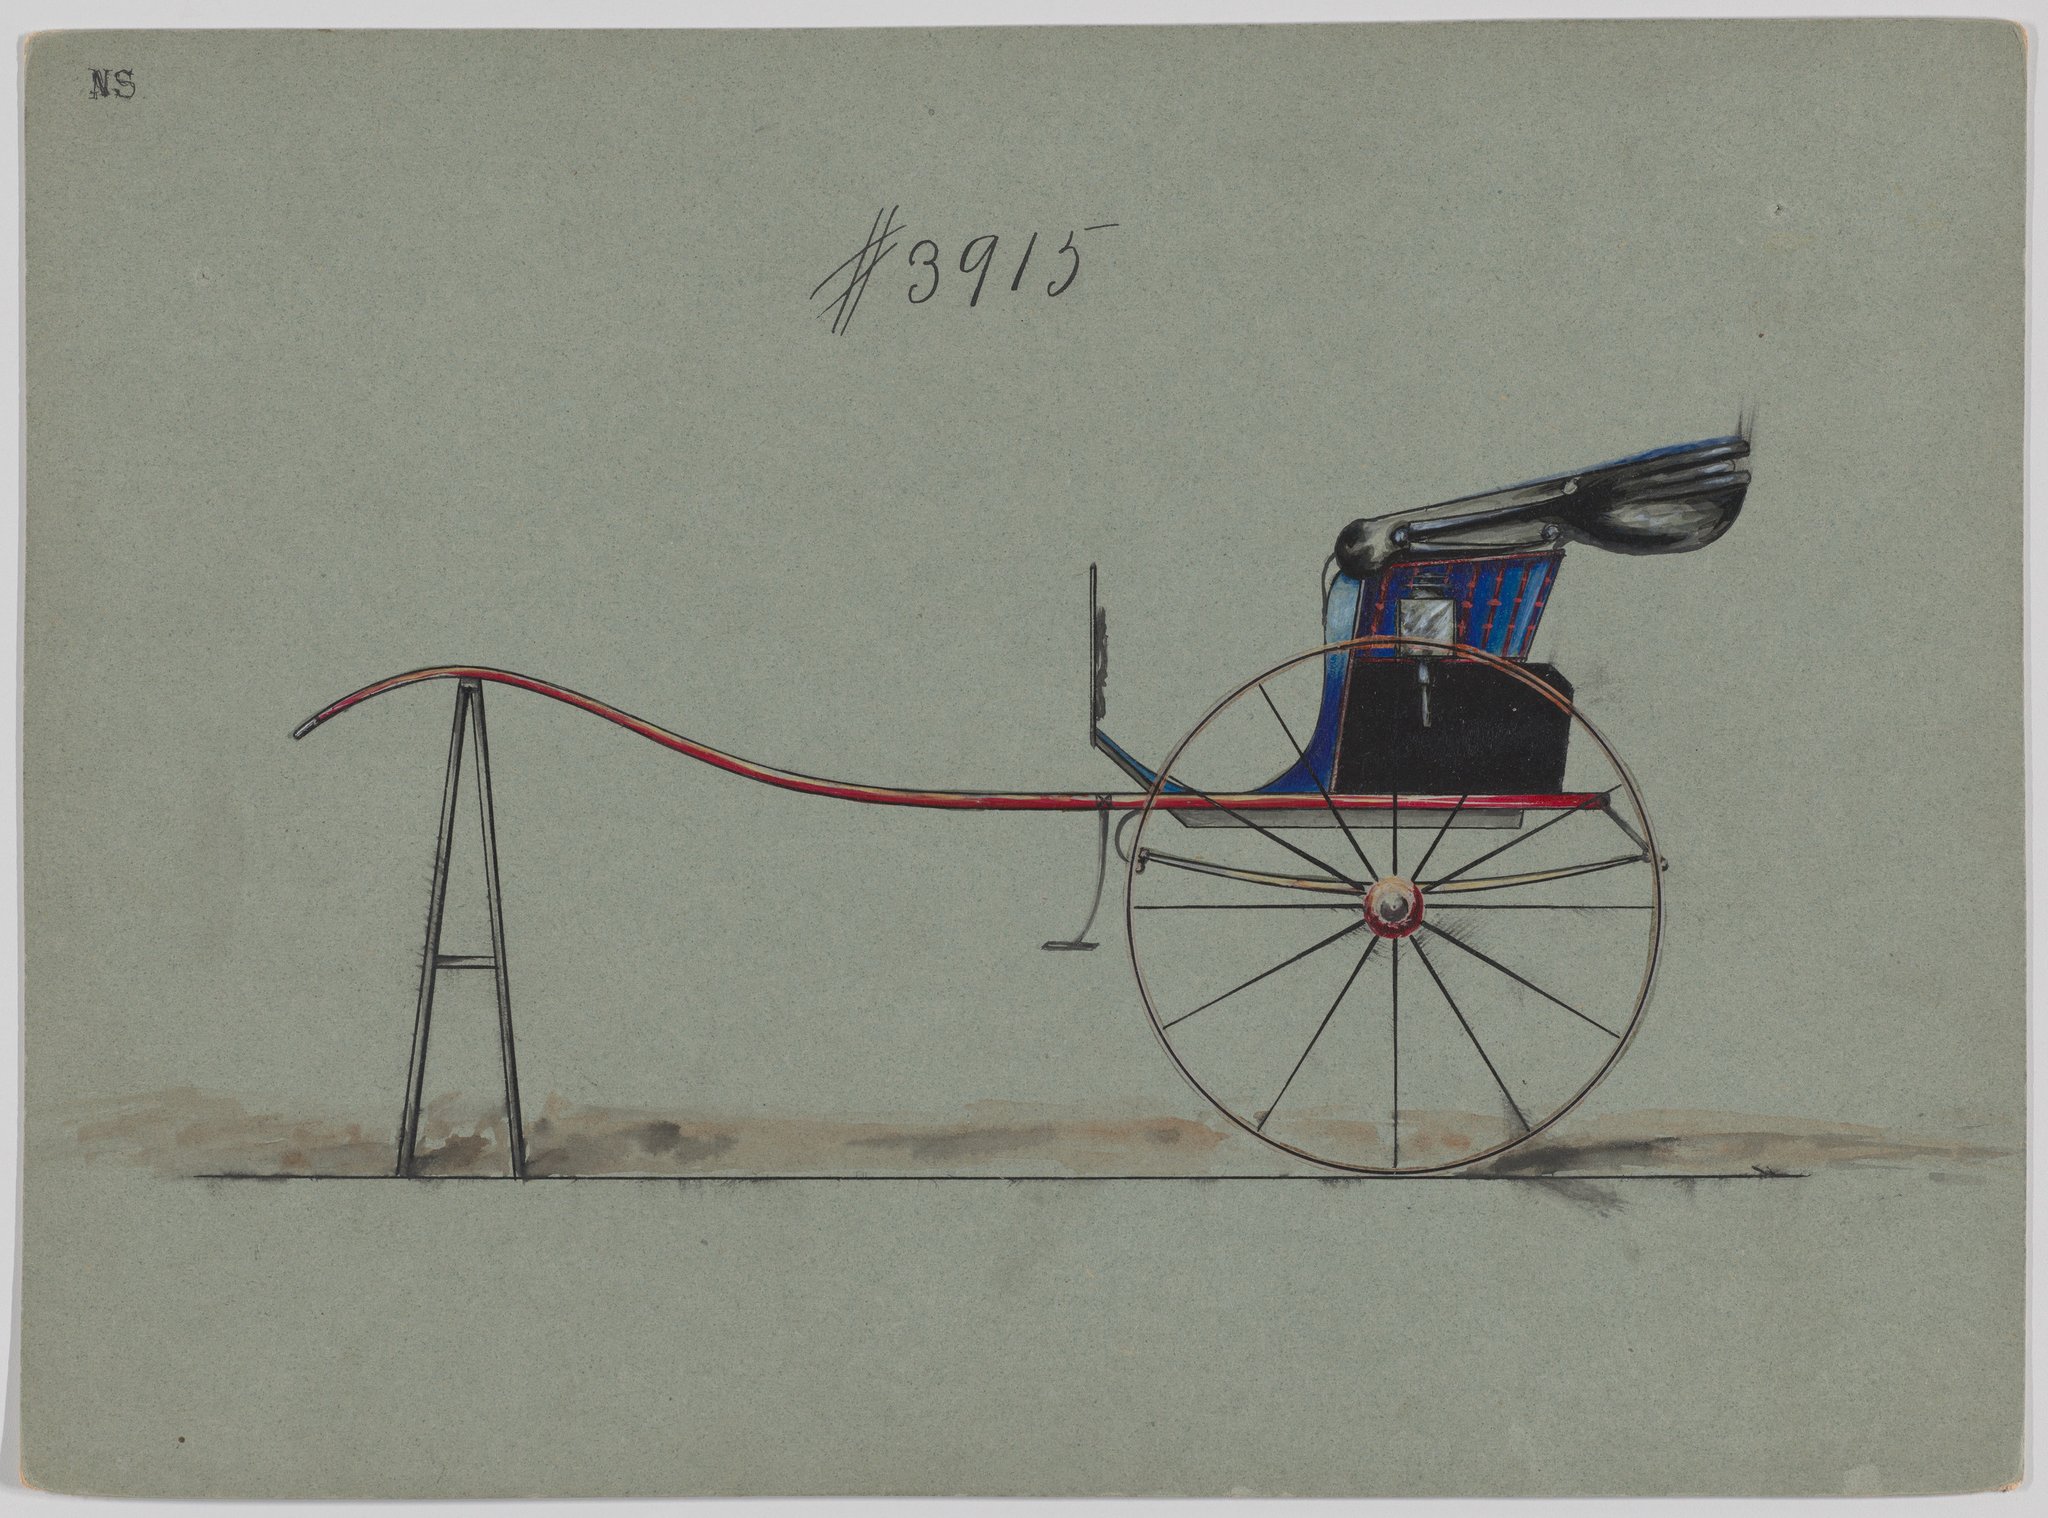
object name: drawing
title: Design for Stanhope Gig, no. 3915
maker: brewster & co.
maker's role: manufacturer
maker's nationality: american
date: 1884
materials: gouache, gum arabic, ink, watercolor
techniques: pen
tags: carriages